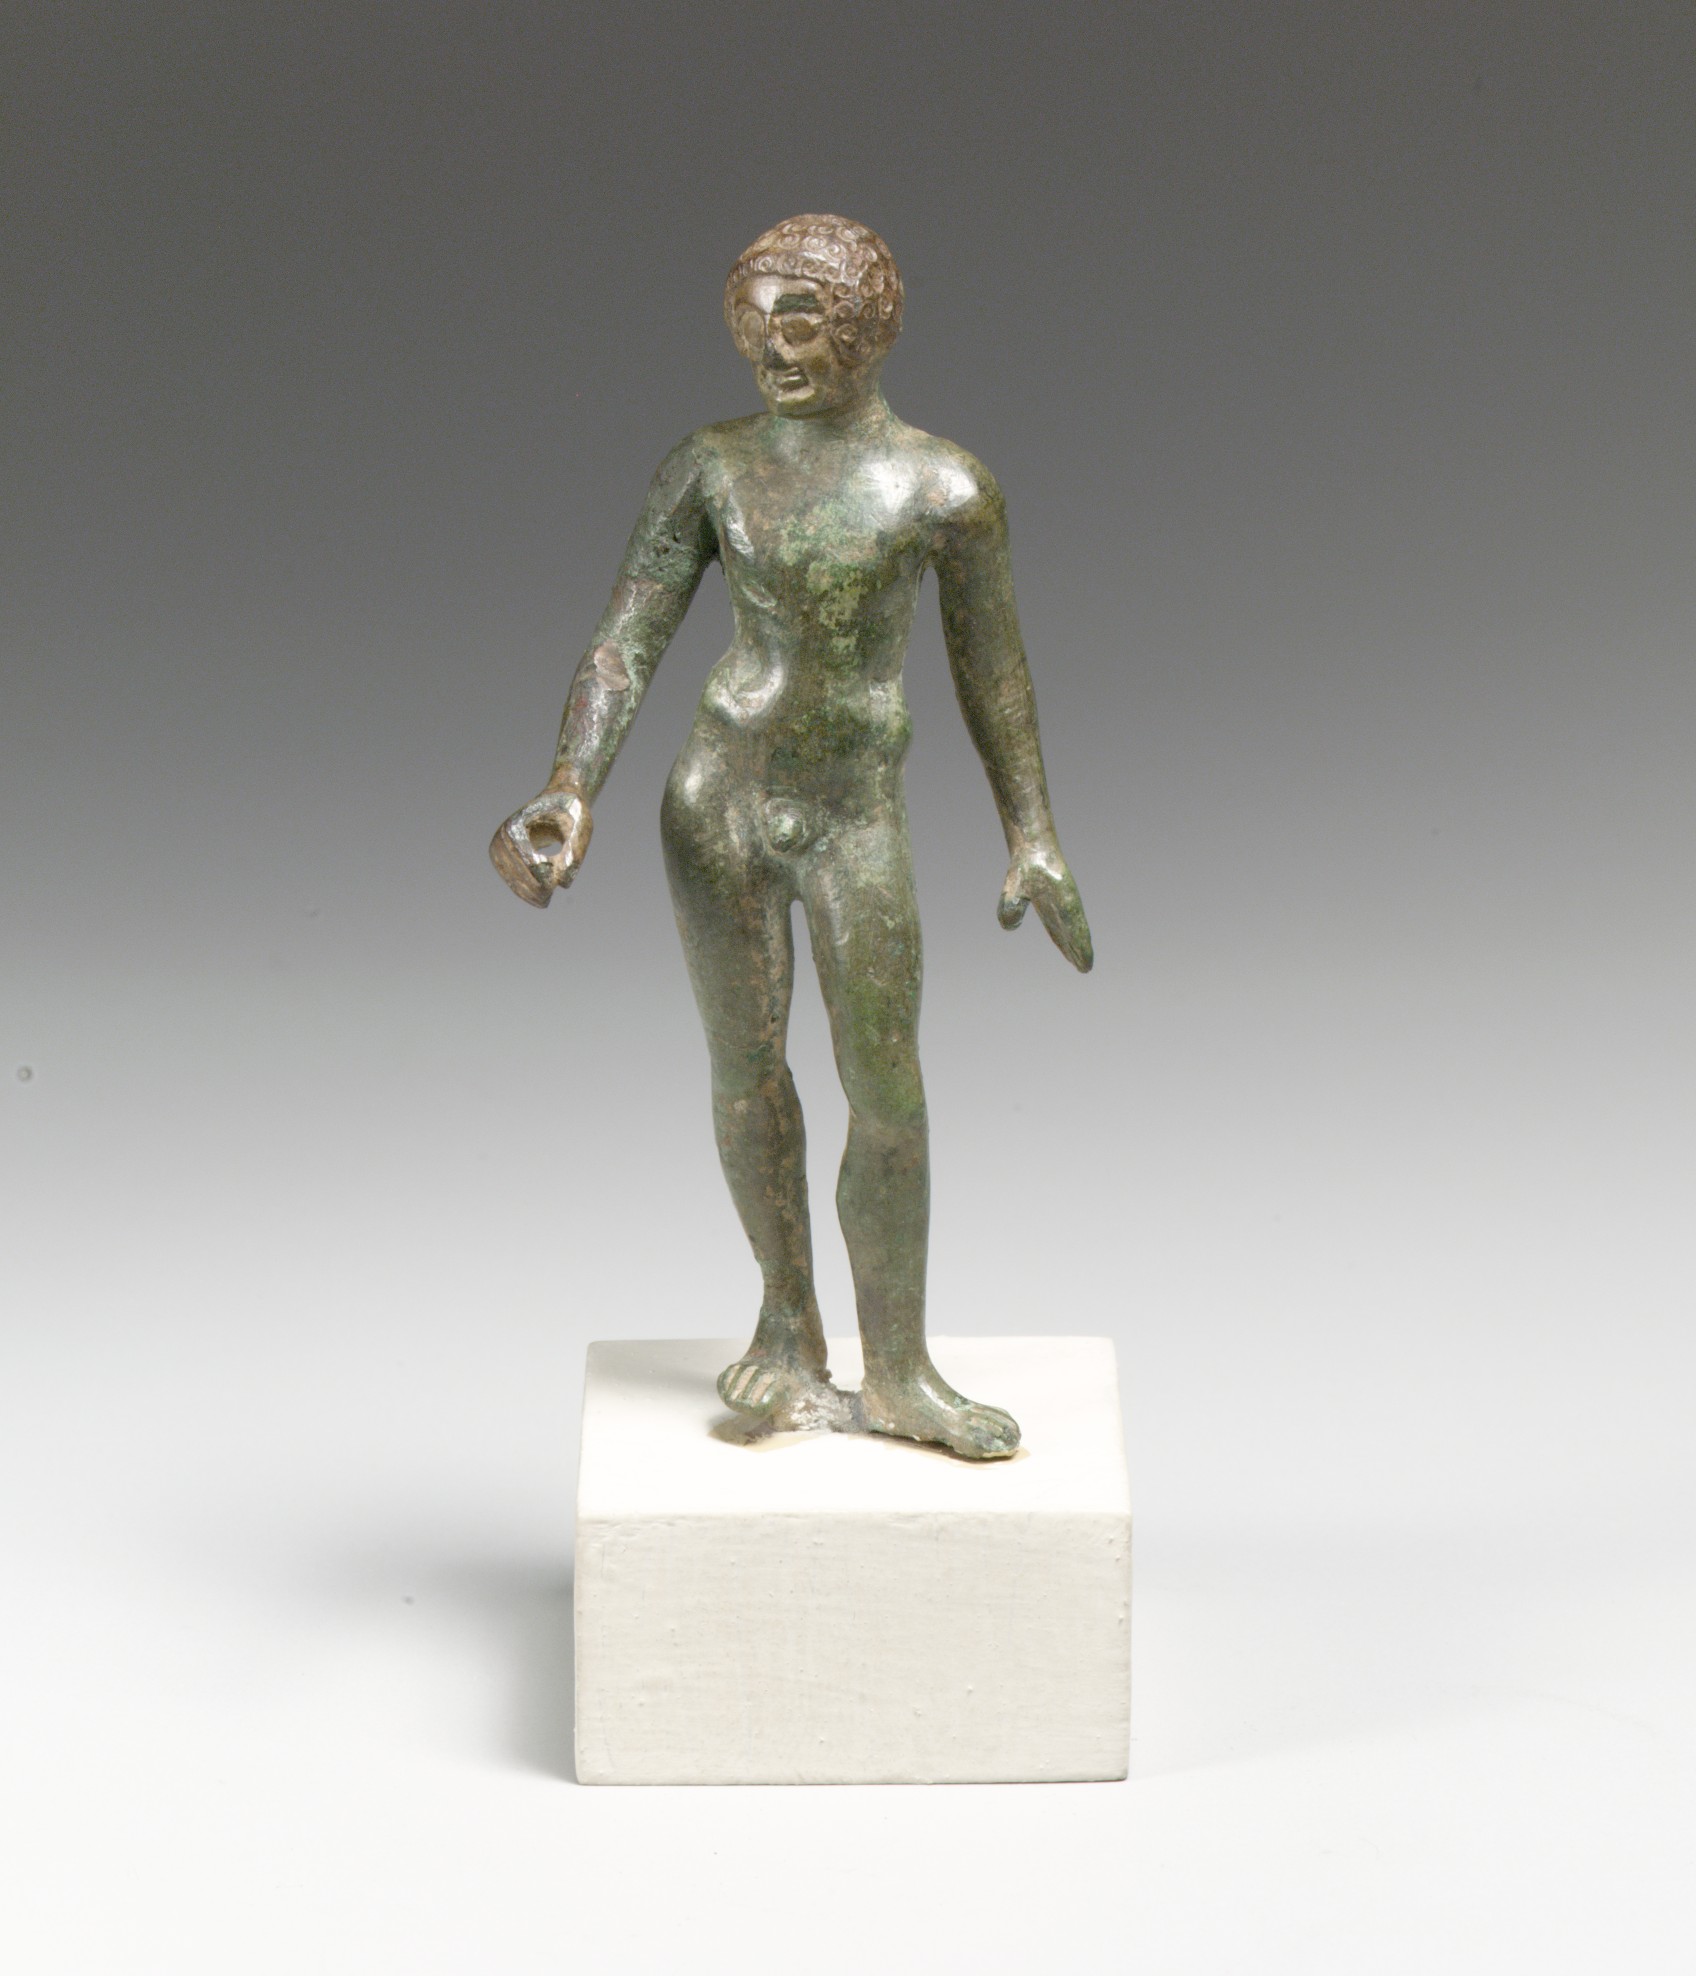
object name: statuette of a youth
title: Bronze statuette of a youth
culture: etruscan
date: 400-201 BCE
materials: bronze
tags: male nudes